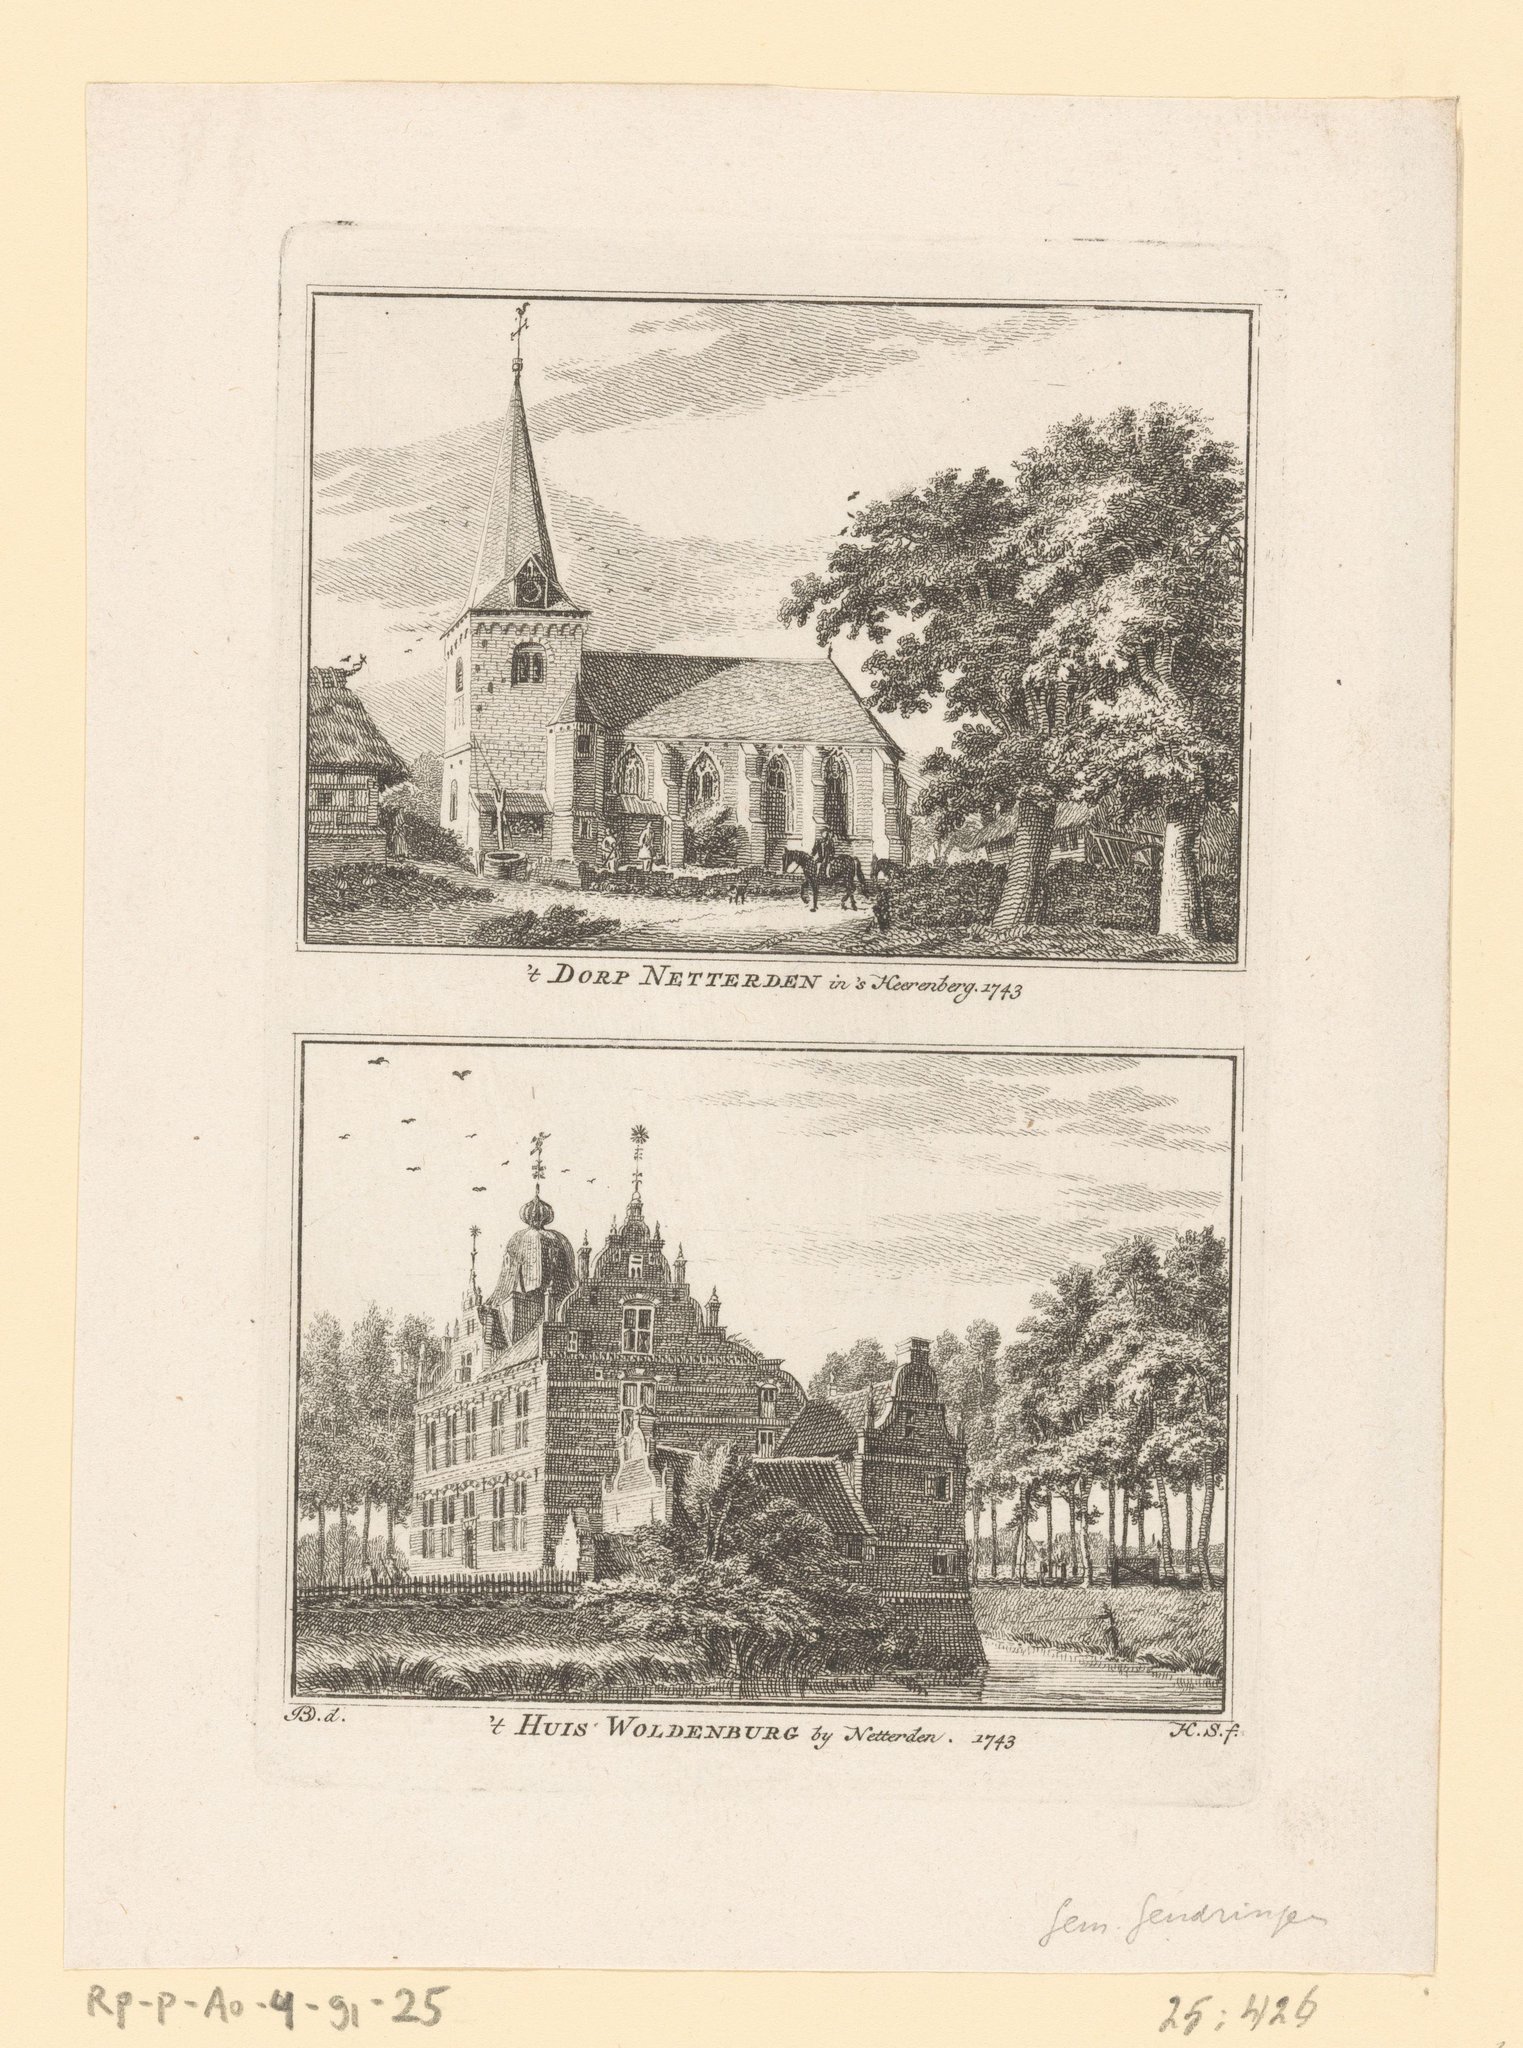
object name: print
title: 't Dorp Netterden in 's Heerenberg. 1743 / 't Huis Woldenburg. 1743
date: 1745-1792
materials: paper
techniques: etching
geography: haarlem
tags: castle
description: Prent ook gebruikt in: Het verheerlykt Nederland of kabinet van hedendaagsche gezigten van steden, dorpen (…). 9 delen. Amsterdam: Isaak Tirion en weduwe Isaak Tirion, 1745-1774, dl. 1 (1745), ill. 71-72. Of in: Nederlandsche tafereelen; of eene keurige verzameling van negen honderd fraaije gezigten van steden, dorpen, sloten, oudheden (….). 9 delen. Amsterdam: Jan de Groot, 1792, dl. 1, ill. 71-72.